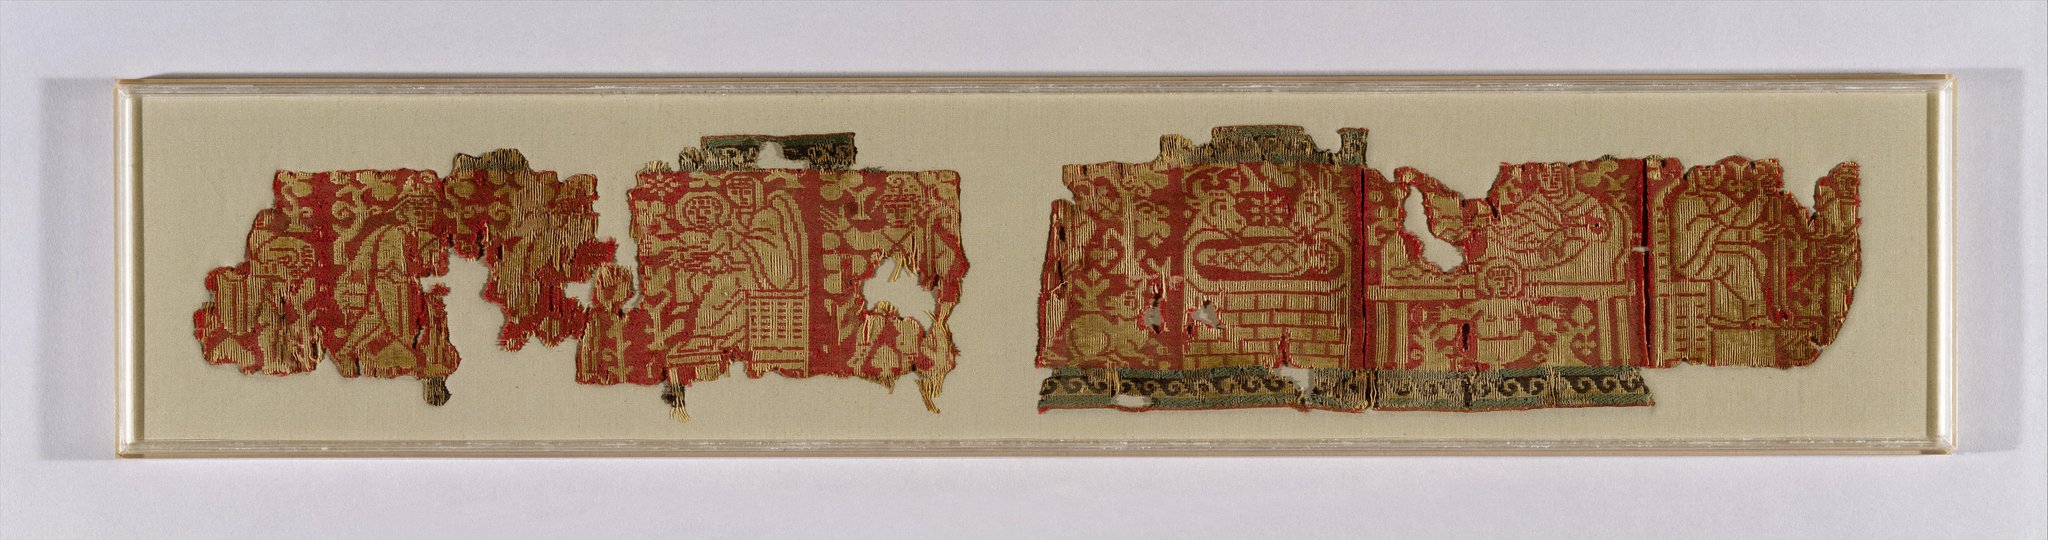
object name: fragmentary band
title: Fragmentary Band with Scenes from the Infancy of Christ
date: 401-600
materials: linen, silk, wool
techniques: weave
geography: egypt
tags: christ,adoration of the shepherds,annunciation,nativity